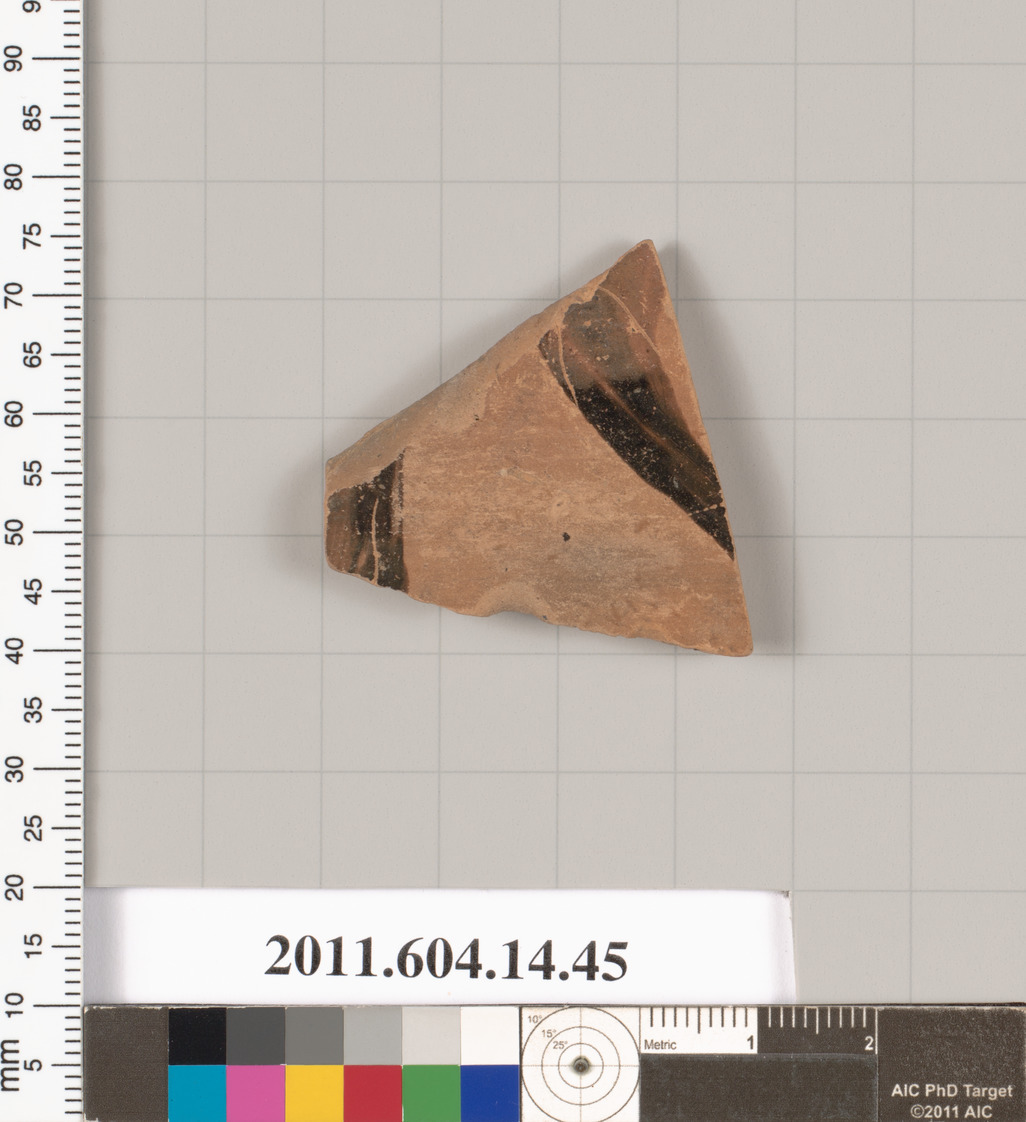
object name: undetermined closed shape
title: Terracotta fragment from a closed shape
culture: unknown fabric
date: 600-401 BCE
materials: terracotta